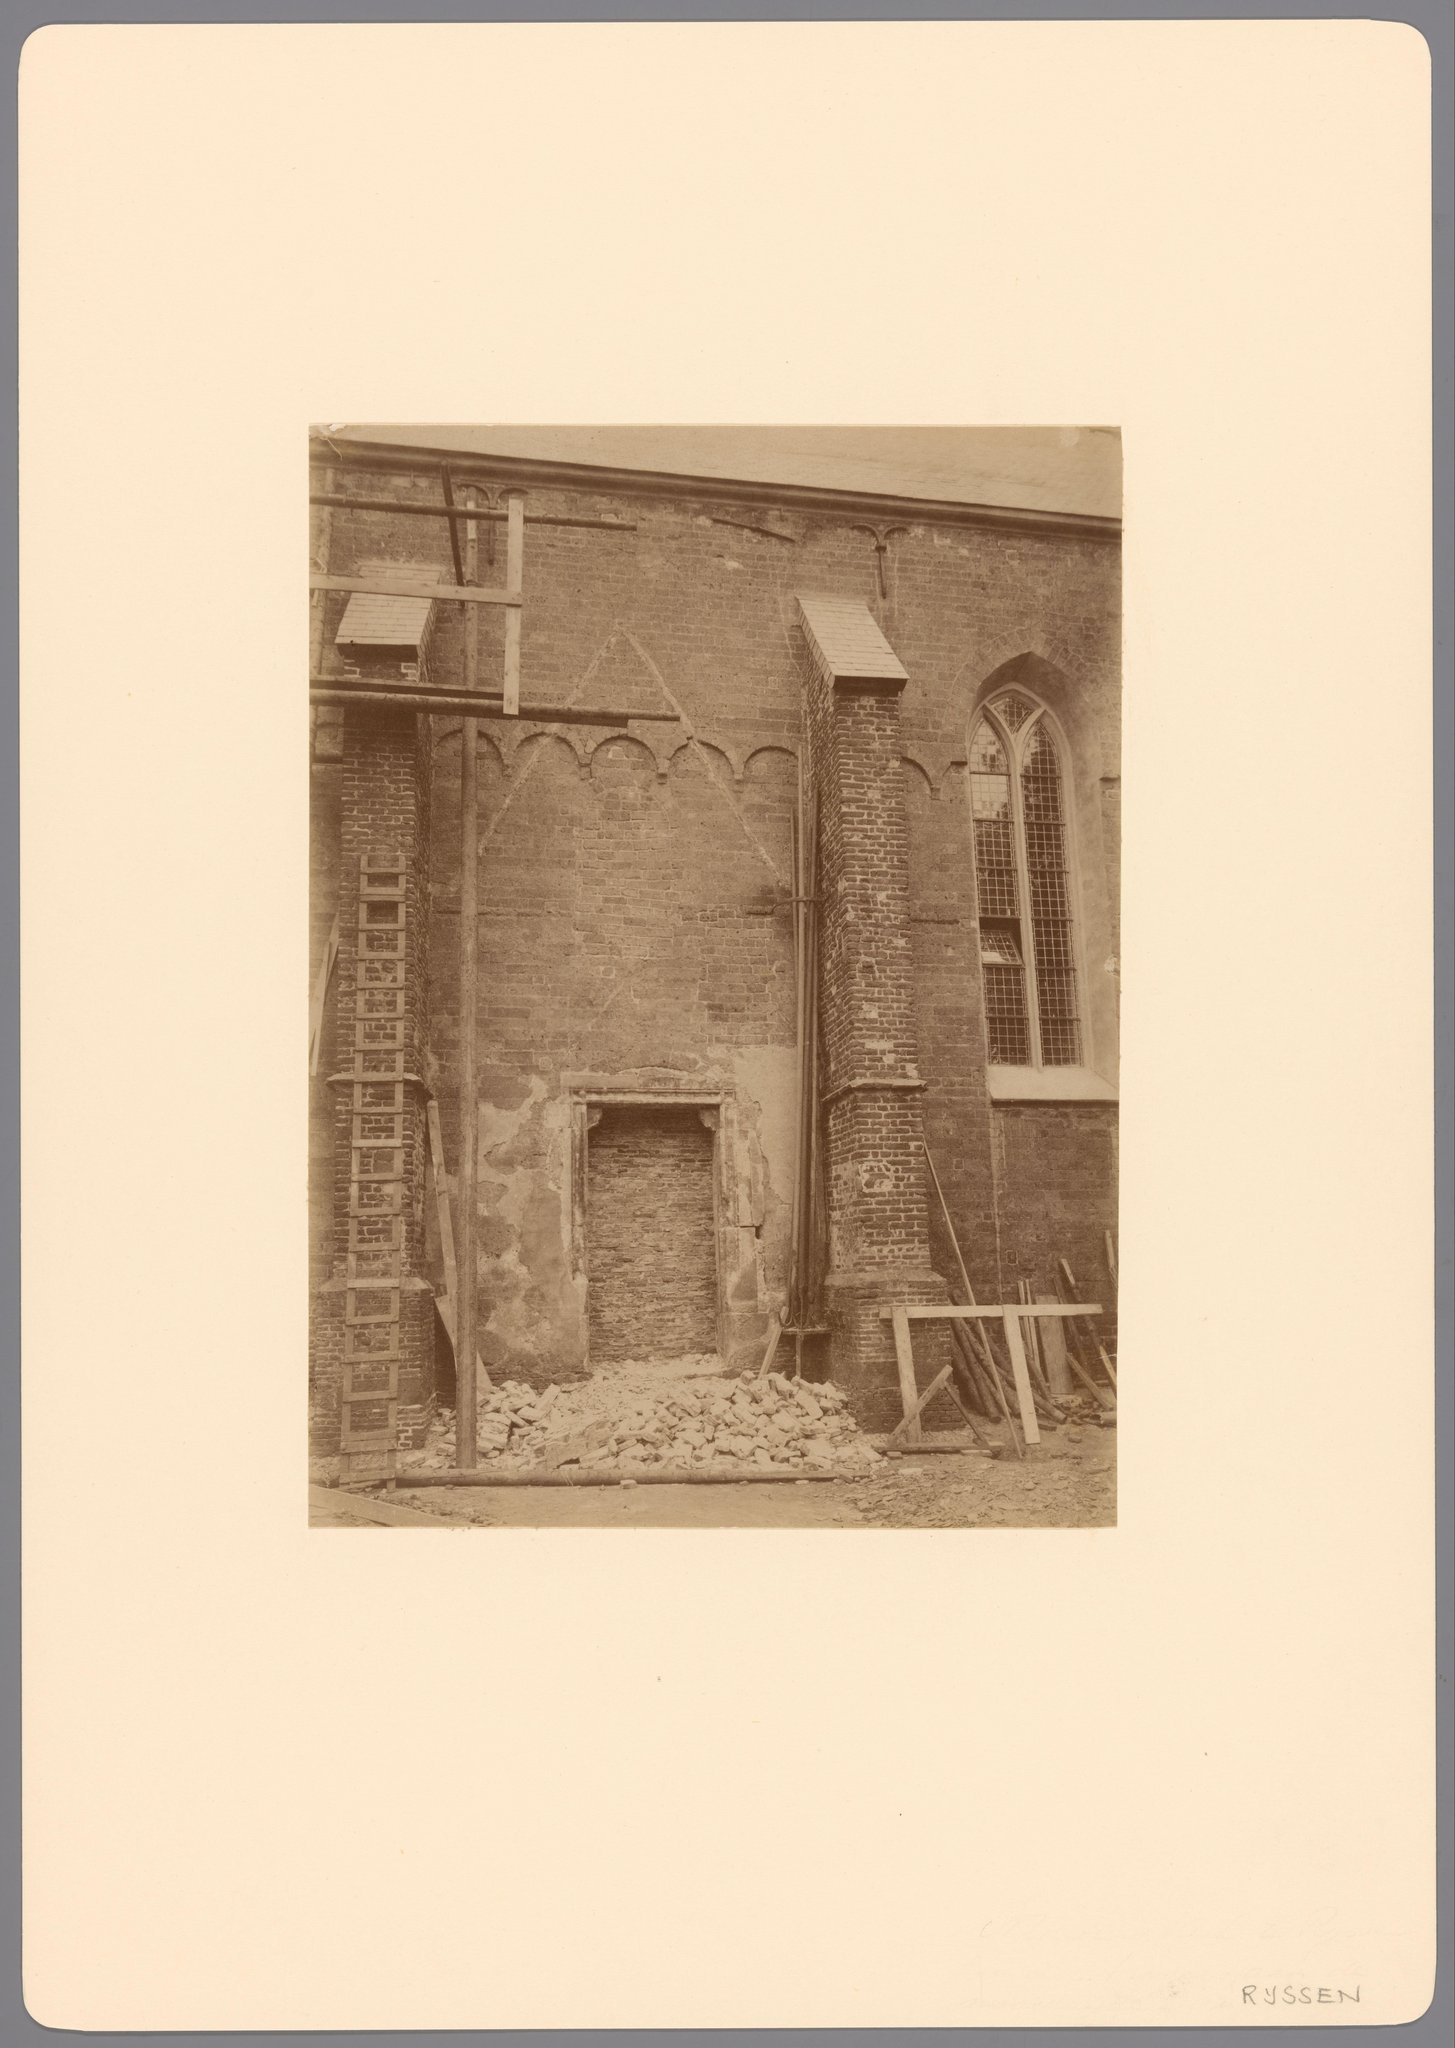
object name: photograph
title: Gewelfjuk van de Grote of Schildkerk te Rijssen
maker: anoniem (monumentenzorg)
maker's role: fotograaf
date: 1899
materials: cardboard, photographic support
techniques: albumen print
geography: rijssen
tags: church (exterior)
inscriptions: annotation: ‘Rijssen’, annotation: ‘Rijssen - Ned. Herv. kerk/ een der travees aan de noordzijde/ aug 1899’